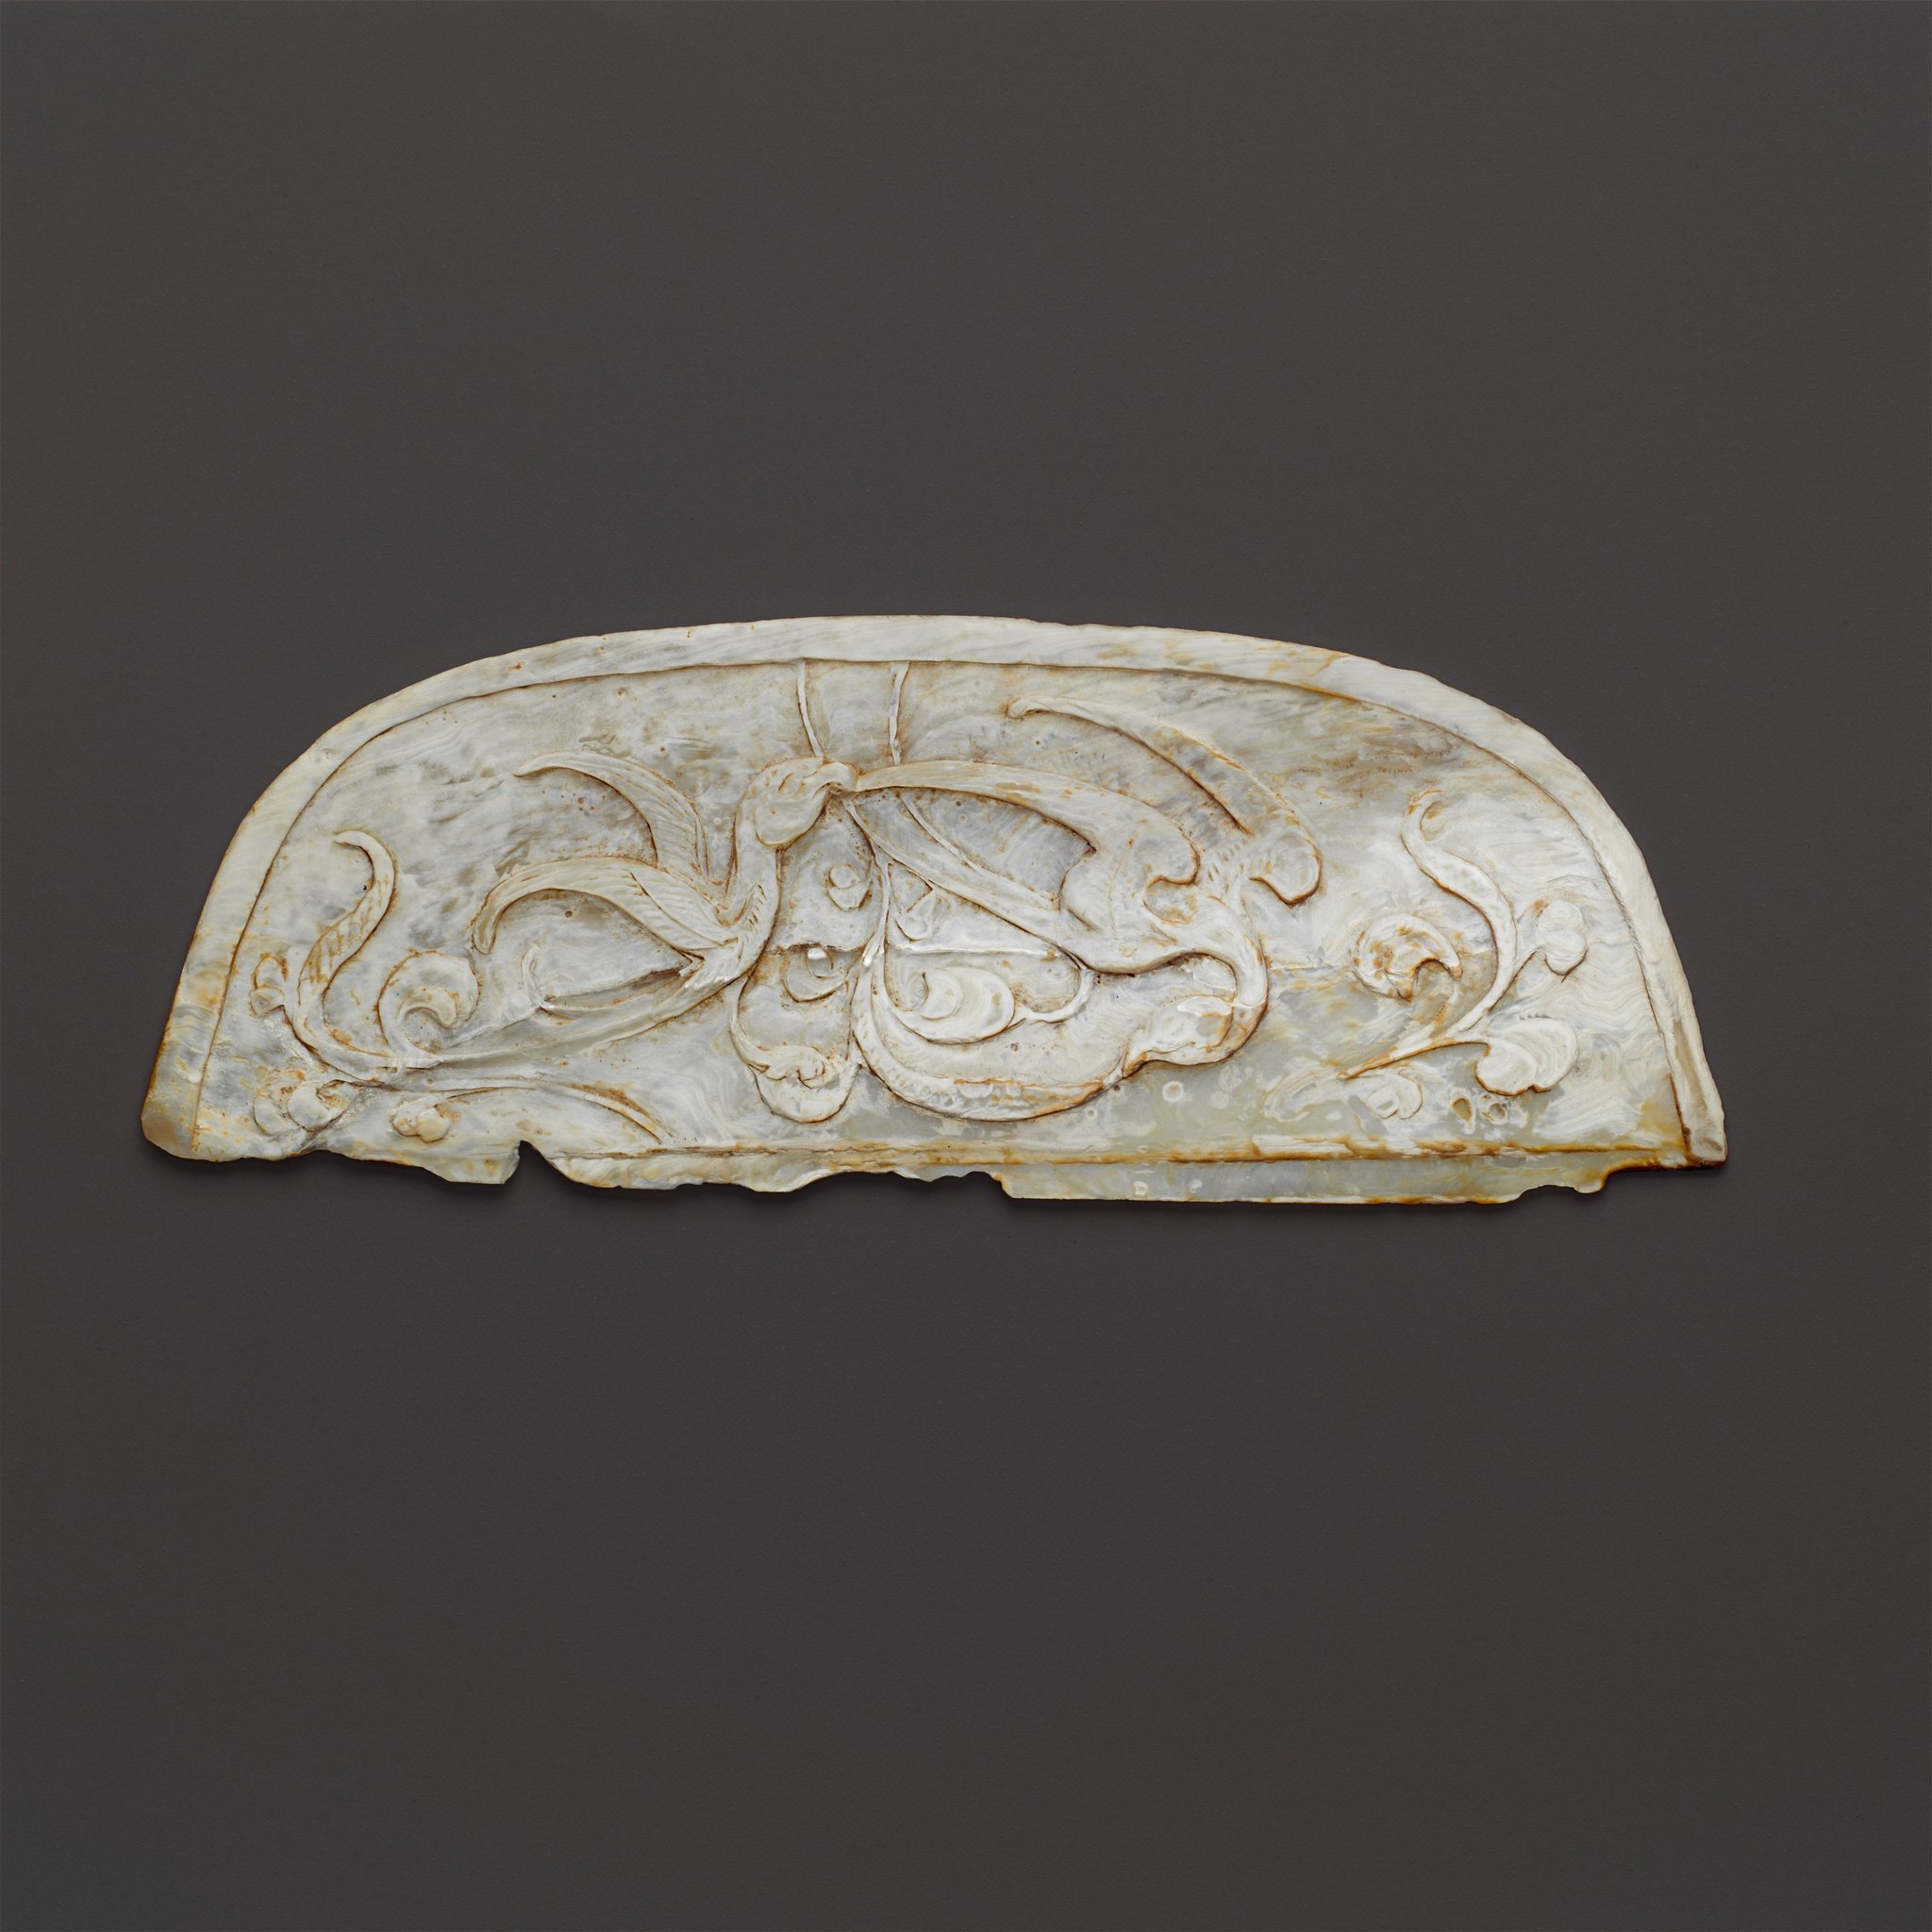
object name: comb top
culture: chinese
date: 701-900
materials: mother of pearl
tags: birds